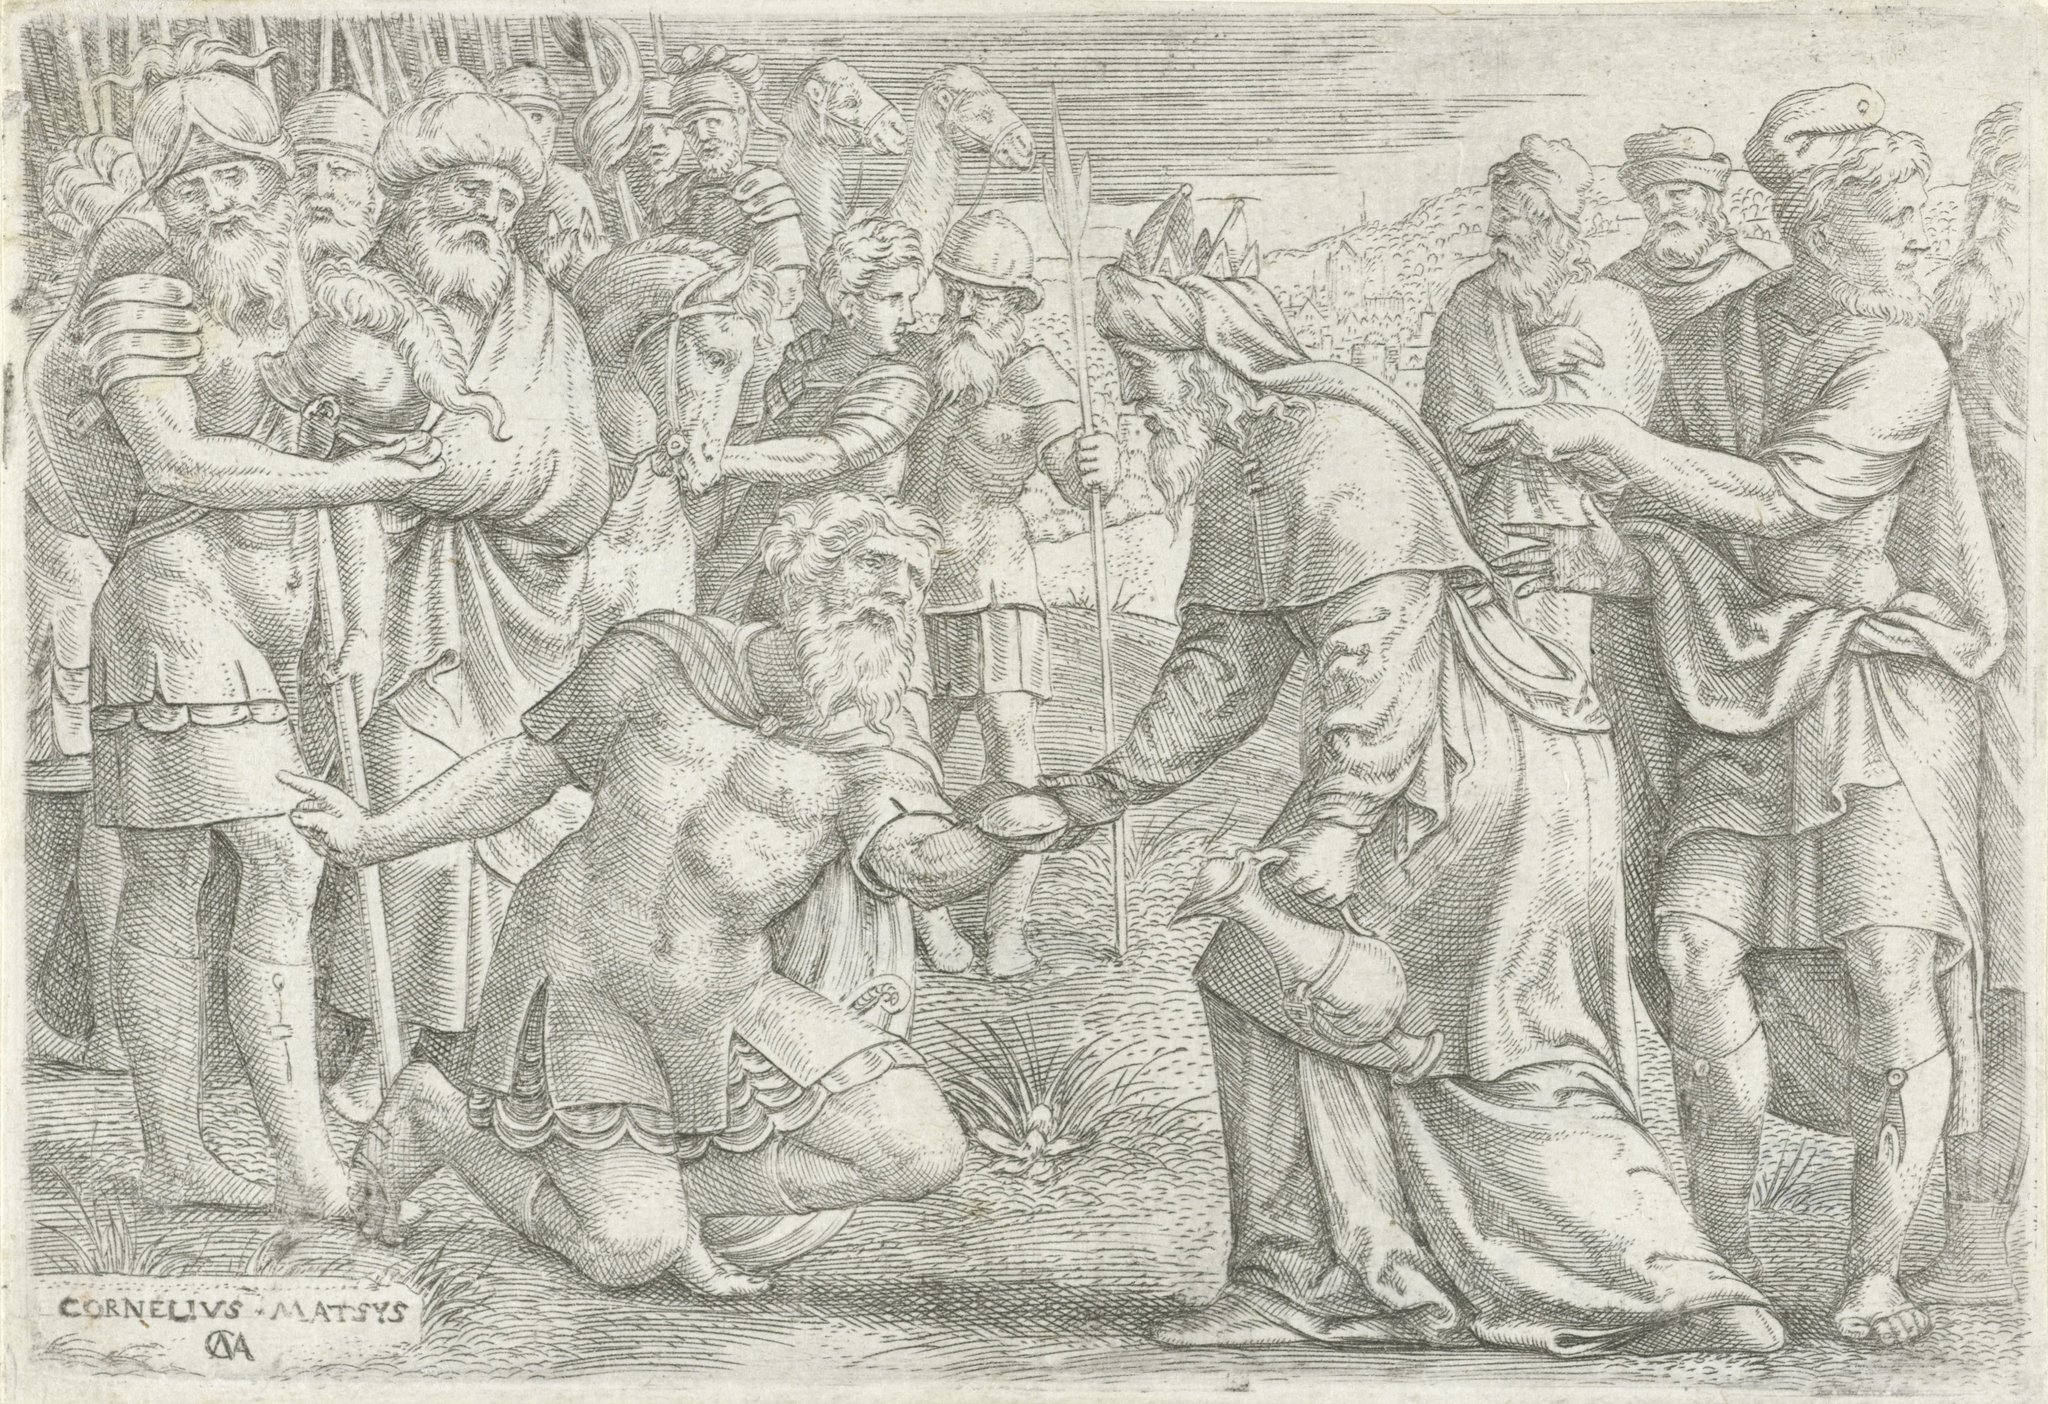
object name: print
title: Abrahams ontmoeting met Melchisedek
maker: cornelis massijs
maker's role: painter, print maker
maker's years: 1510-1557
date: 1545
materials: paper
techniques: engraving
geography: antwerp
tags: the meeting of abraham and melchizedek, the high priest and king of salem, who brings bread and wine (genesis 14:18-20)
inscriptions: collector's mark: Lugt 109, collector's mark: Lugt 2228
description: Melchisedek, de hogepriester en koning van Salem (Jeruzalem), geeft Abraham brood en een kan met wijn. Abraham knielt voor hem, terwijl achter hem zijn soldaten met paarden en kamelen staan. Achter Melchisedek staan volgelingen van hem.